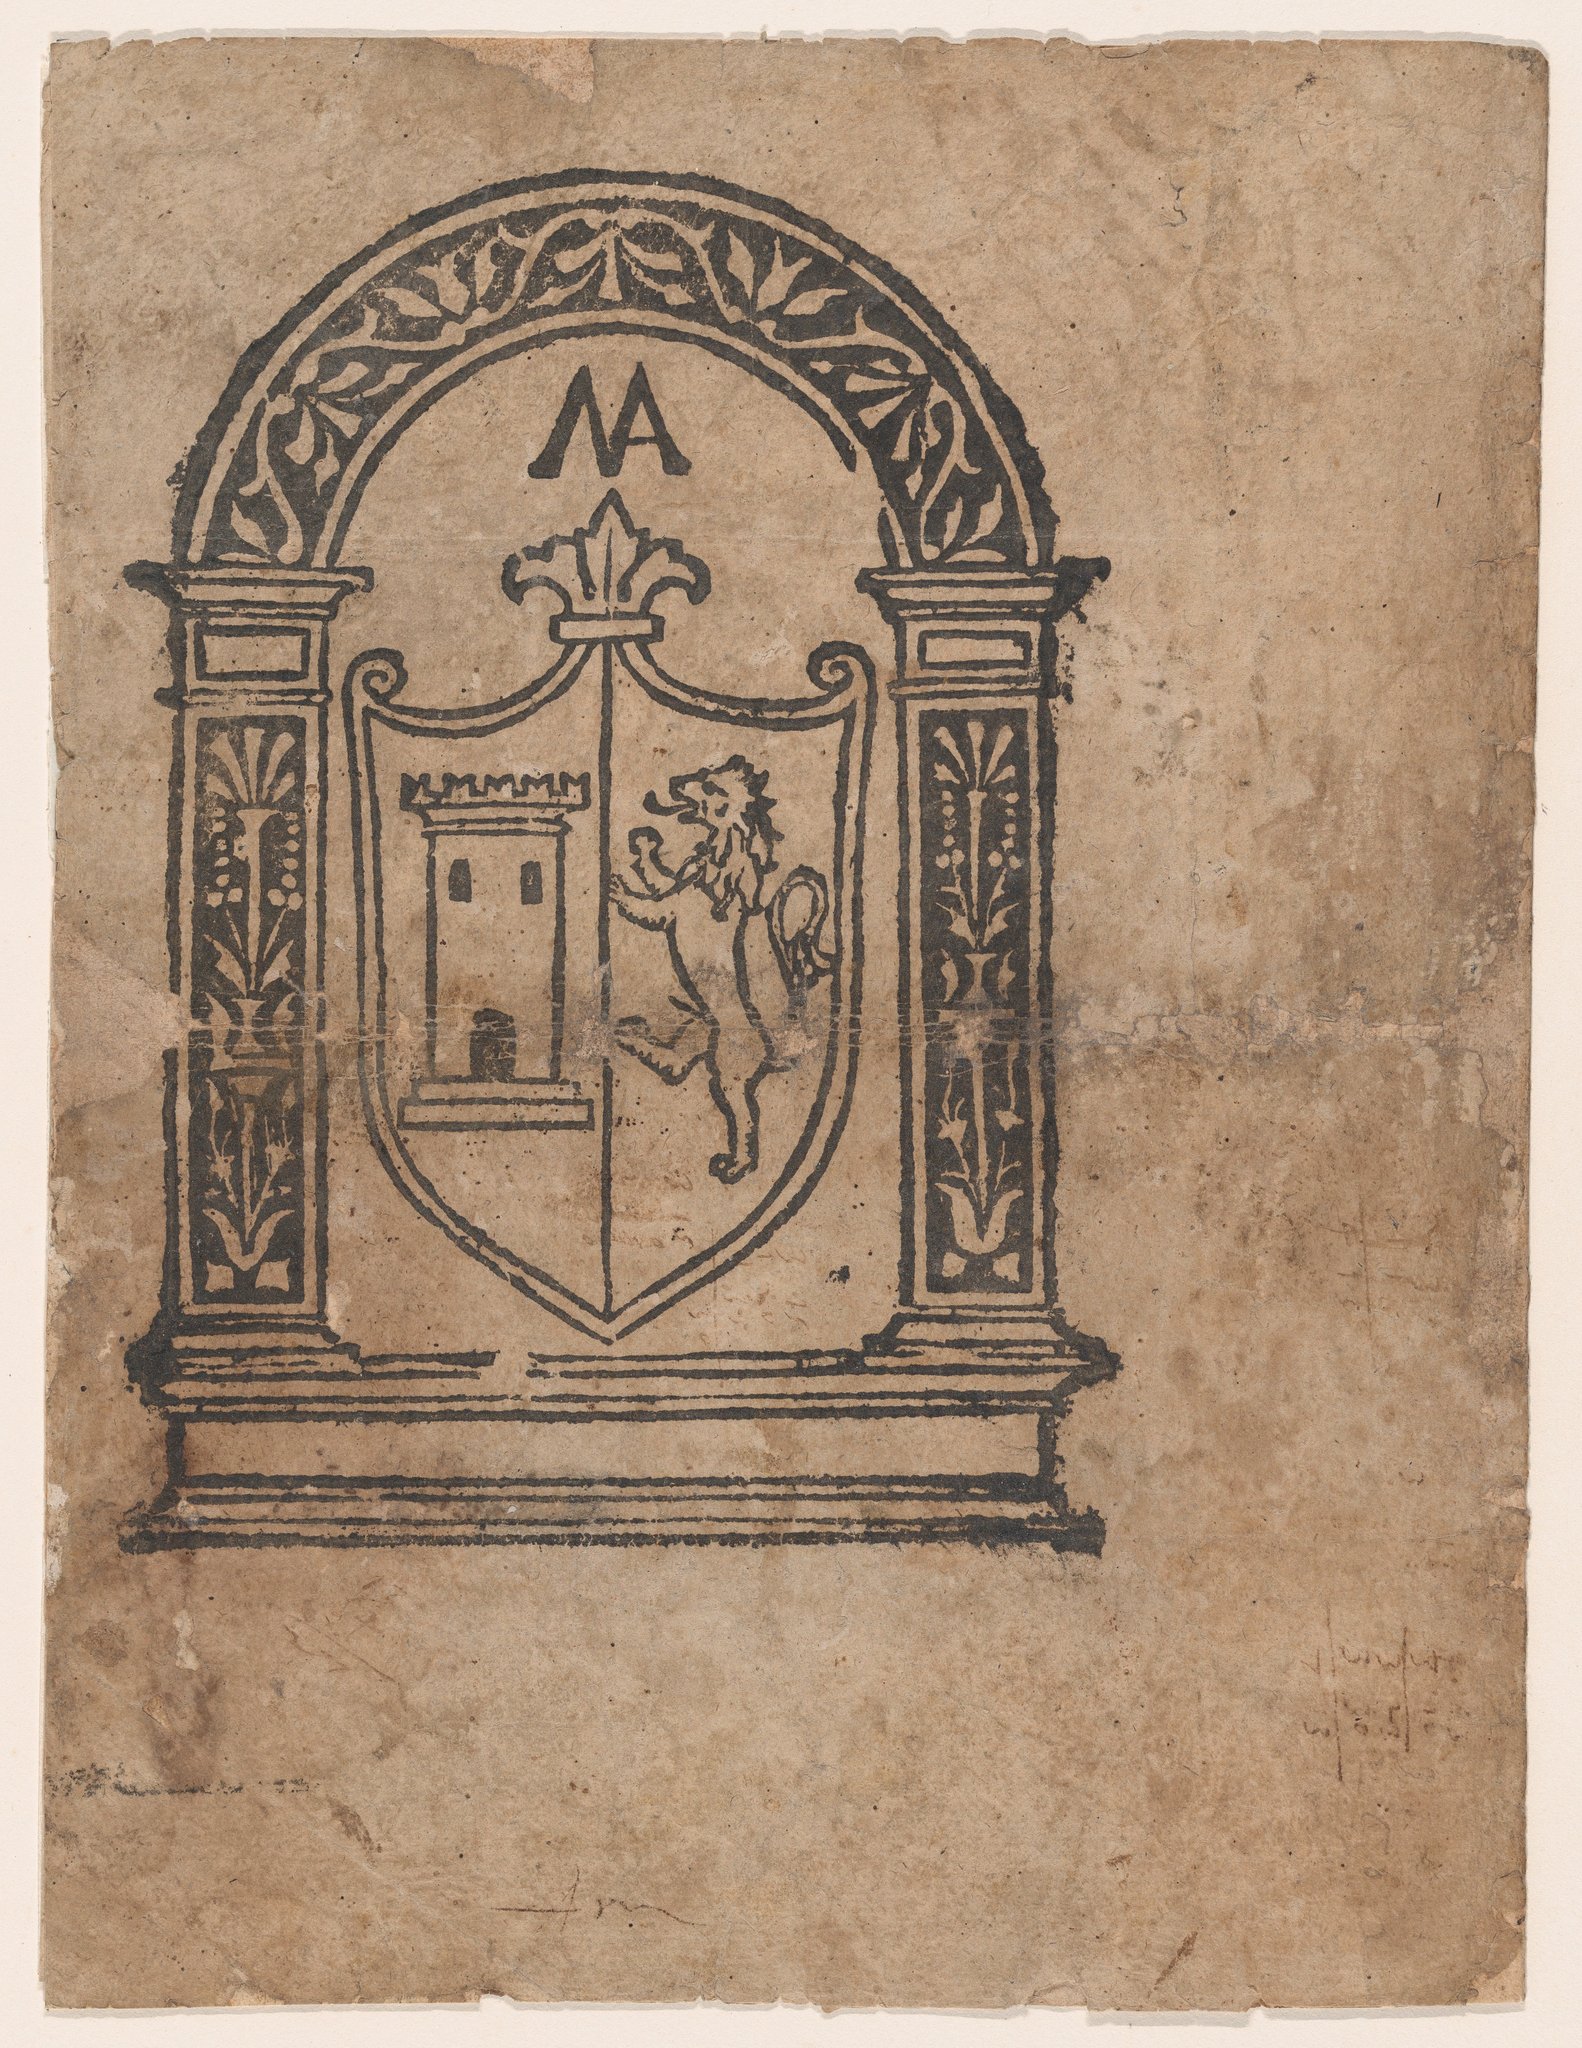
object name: print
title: Book illustration or more likely a trademark with a coat of arms featuring a lion and a tower set within an arch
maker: anonymous, italian, 16th century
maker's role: artist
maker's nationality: italian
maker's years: 1500-1600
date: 1501-1600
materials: ink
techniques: pen, woodcut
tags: coat of arms